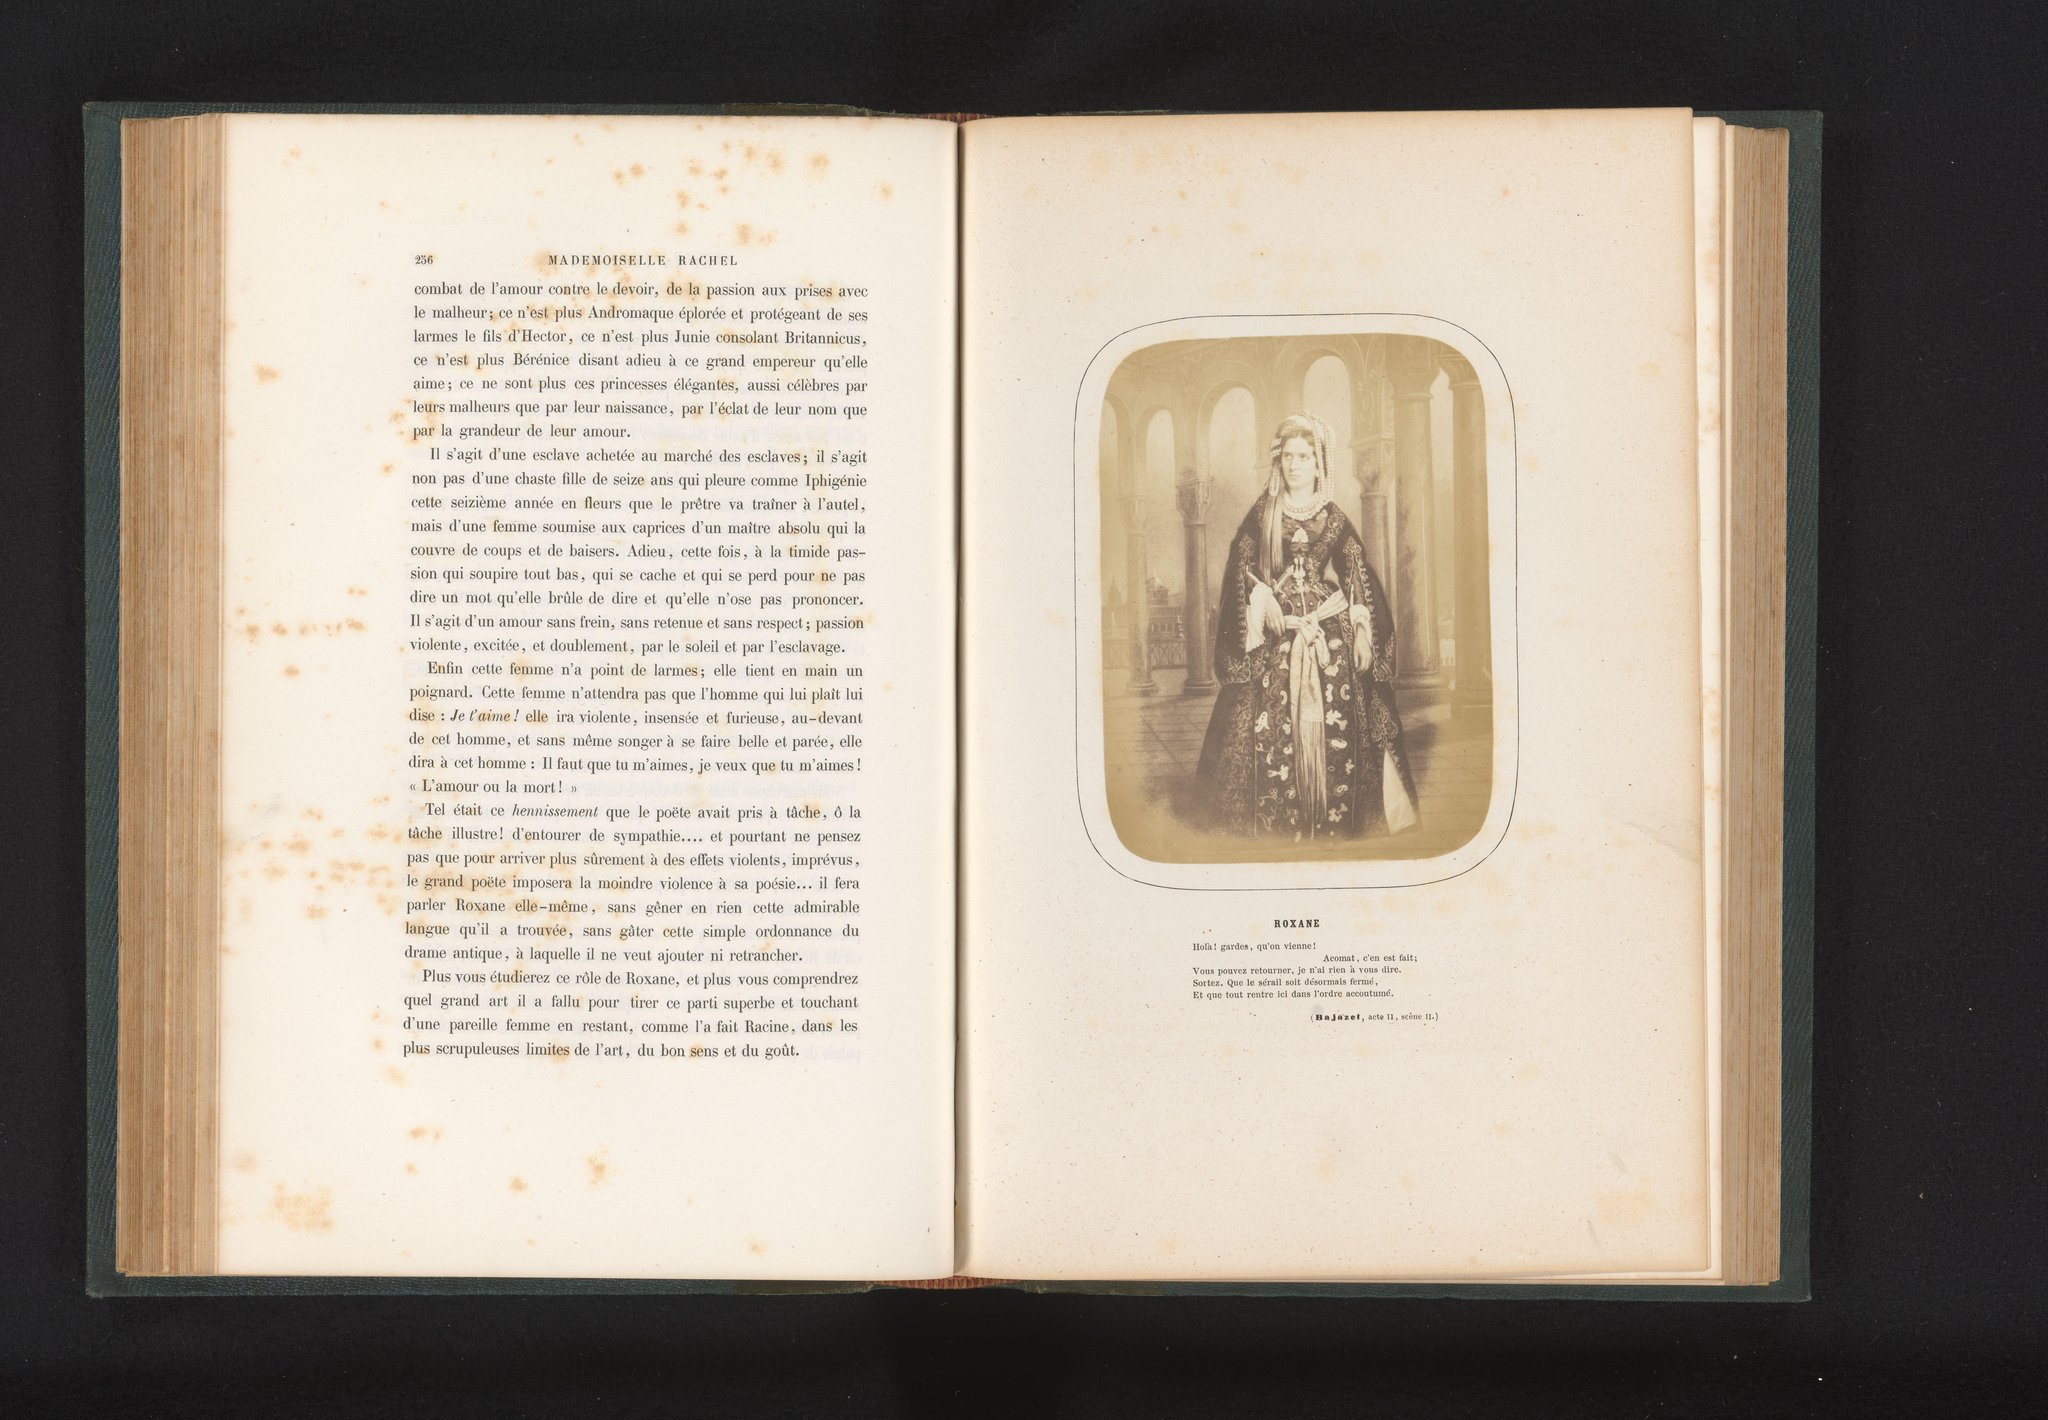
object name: page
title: Roxane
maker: henri de la blanchère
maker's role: fotograaf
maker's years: 1821-1880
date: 1854-1859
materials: paper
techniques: albumen print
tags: portrait of actor, actress, picture, painting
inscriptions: inscription: ‘Holà! gardes, qu'on vienne!/ Acomat, c'en est fait;/ Vous pouves retourner, je n'ai rien à vous dire./ Sortez. Que le sérail doit désormais fermé/ Et que tout rentre ici dans l'ordre accoutumé./ (Bajazet, acte II, scène II.)’